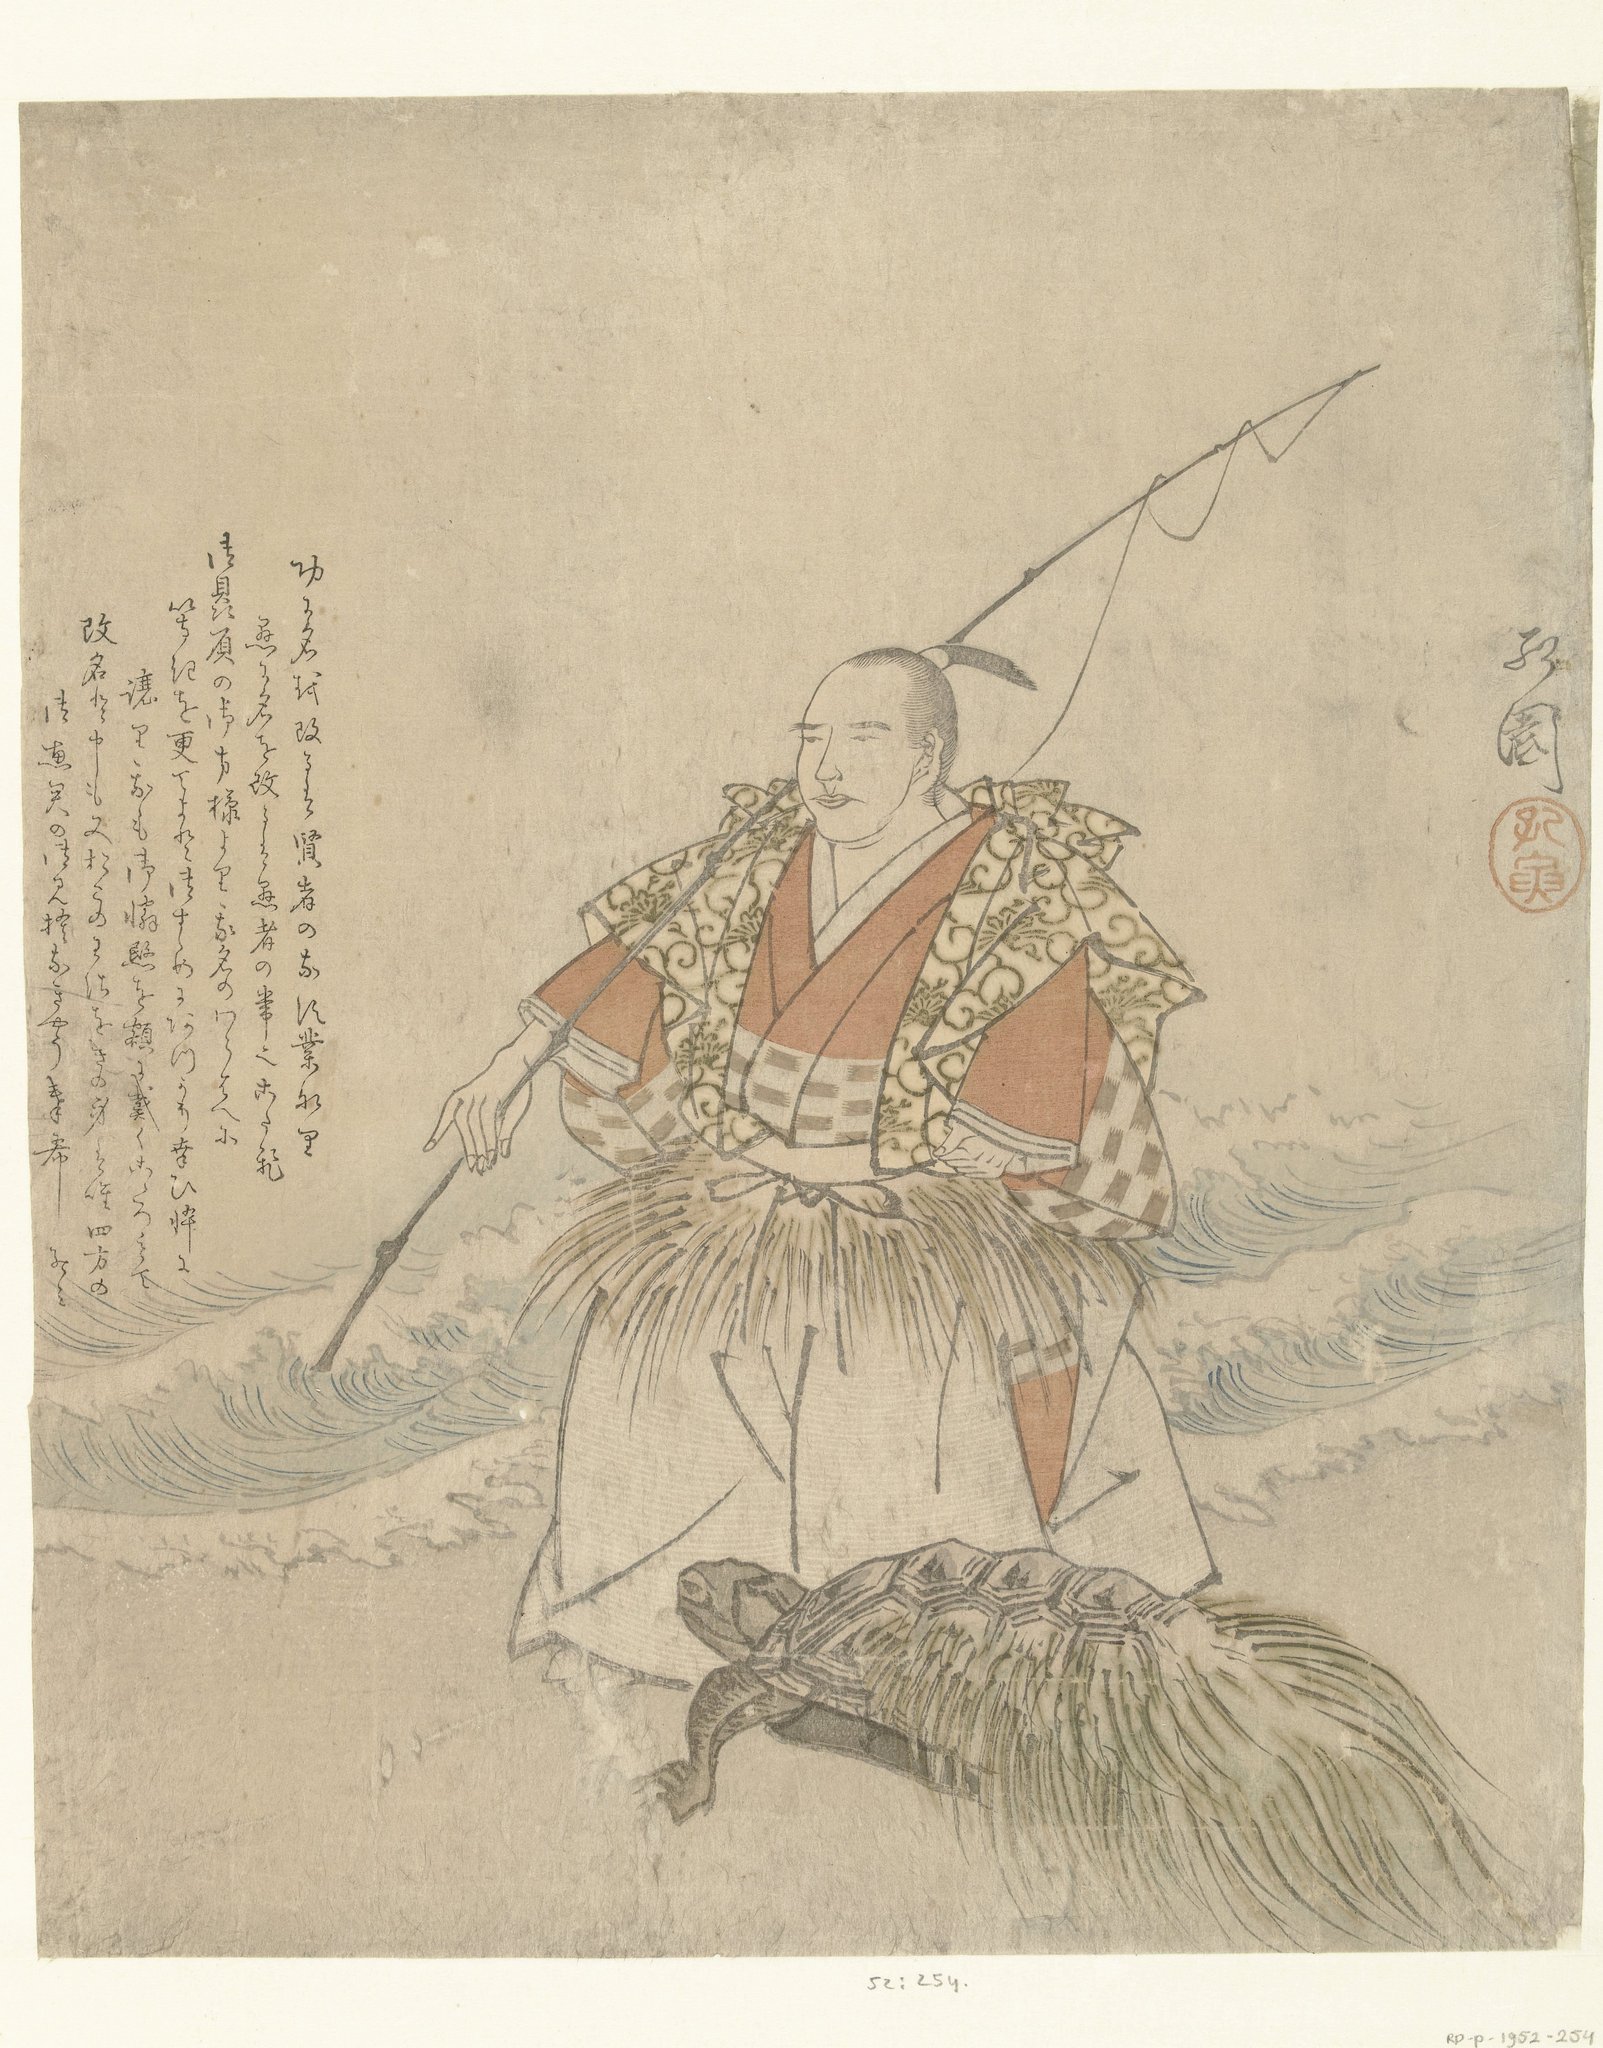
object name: print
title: Urashima Taro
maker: koen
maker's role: print maker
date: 1860-1870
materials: paper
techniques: blind stamped, woodcut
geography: japan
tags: tortoises, turtles, adult man, fisherman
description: Een surimono is een luxe uitgevoerde prent waarop beeld met één of meerdere gedichten gecombineerd is. Bij het drukken van een surimono werd vaak gebruik gemaakt van dikker papier, blinddruk en metaal pigmenten, zoals koper- en zilverpoeder. De prenten werden vaak in opdracht van dichters gemaakt en als exclusief geschenk aan vrienden en relaties gegeven.